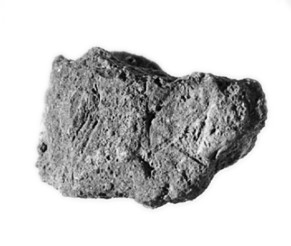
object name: sealing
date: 1981-1640 BCE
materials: mud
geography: egypt